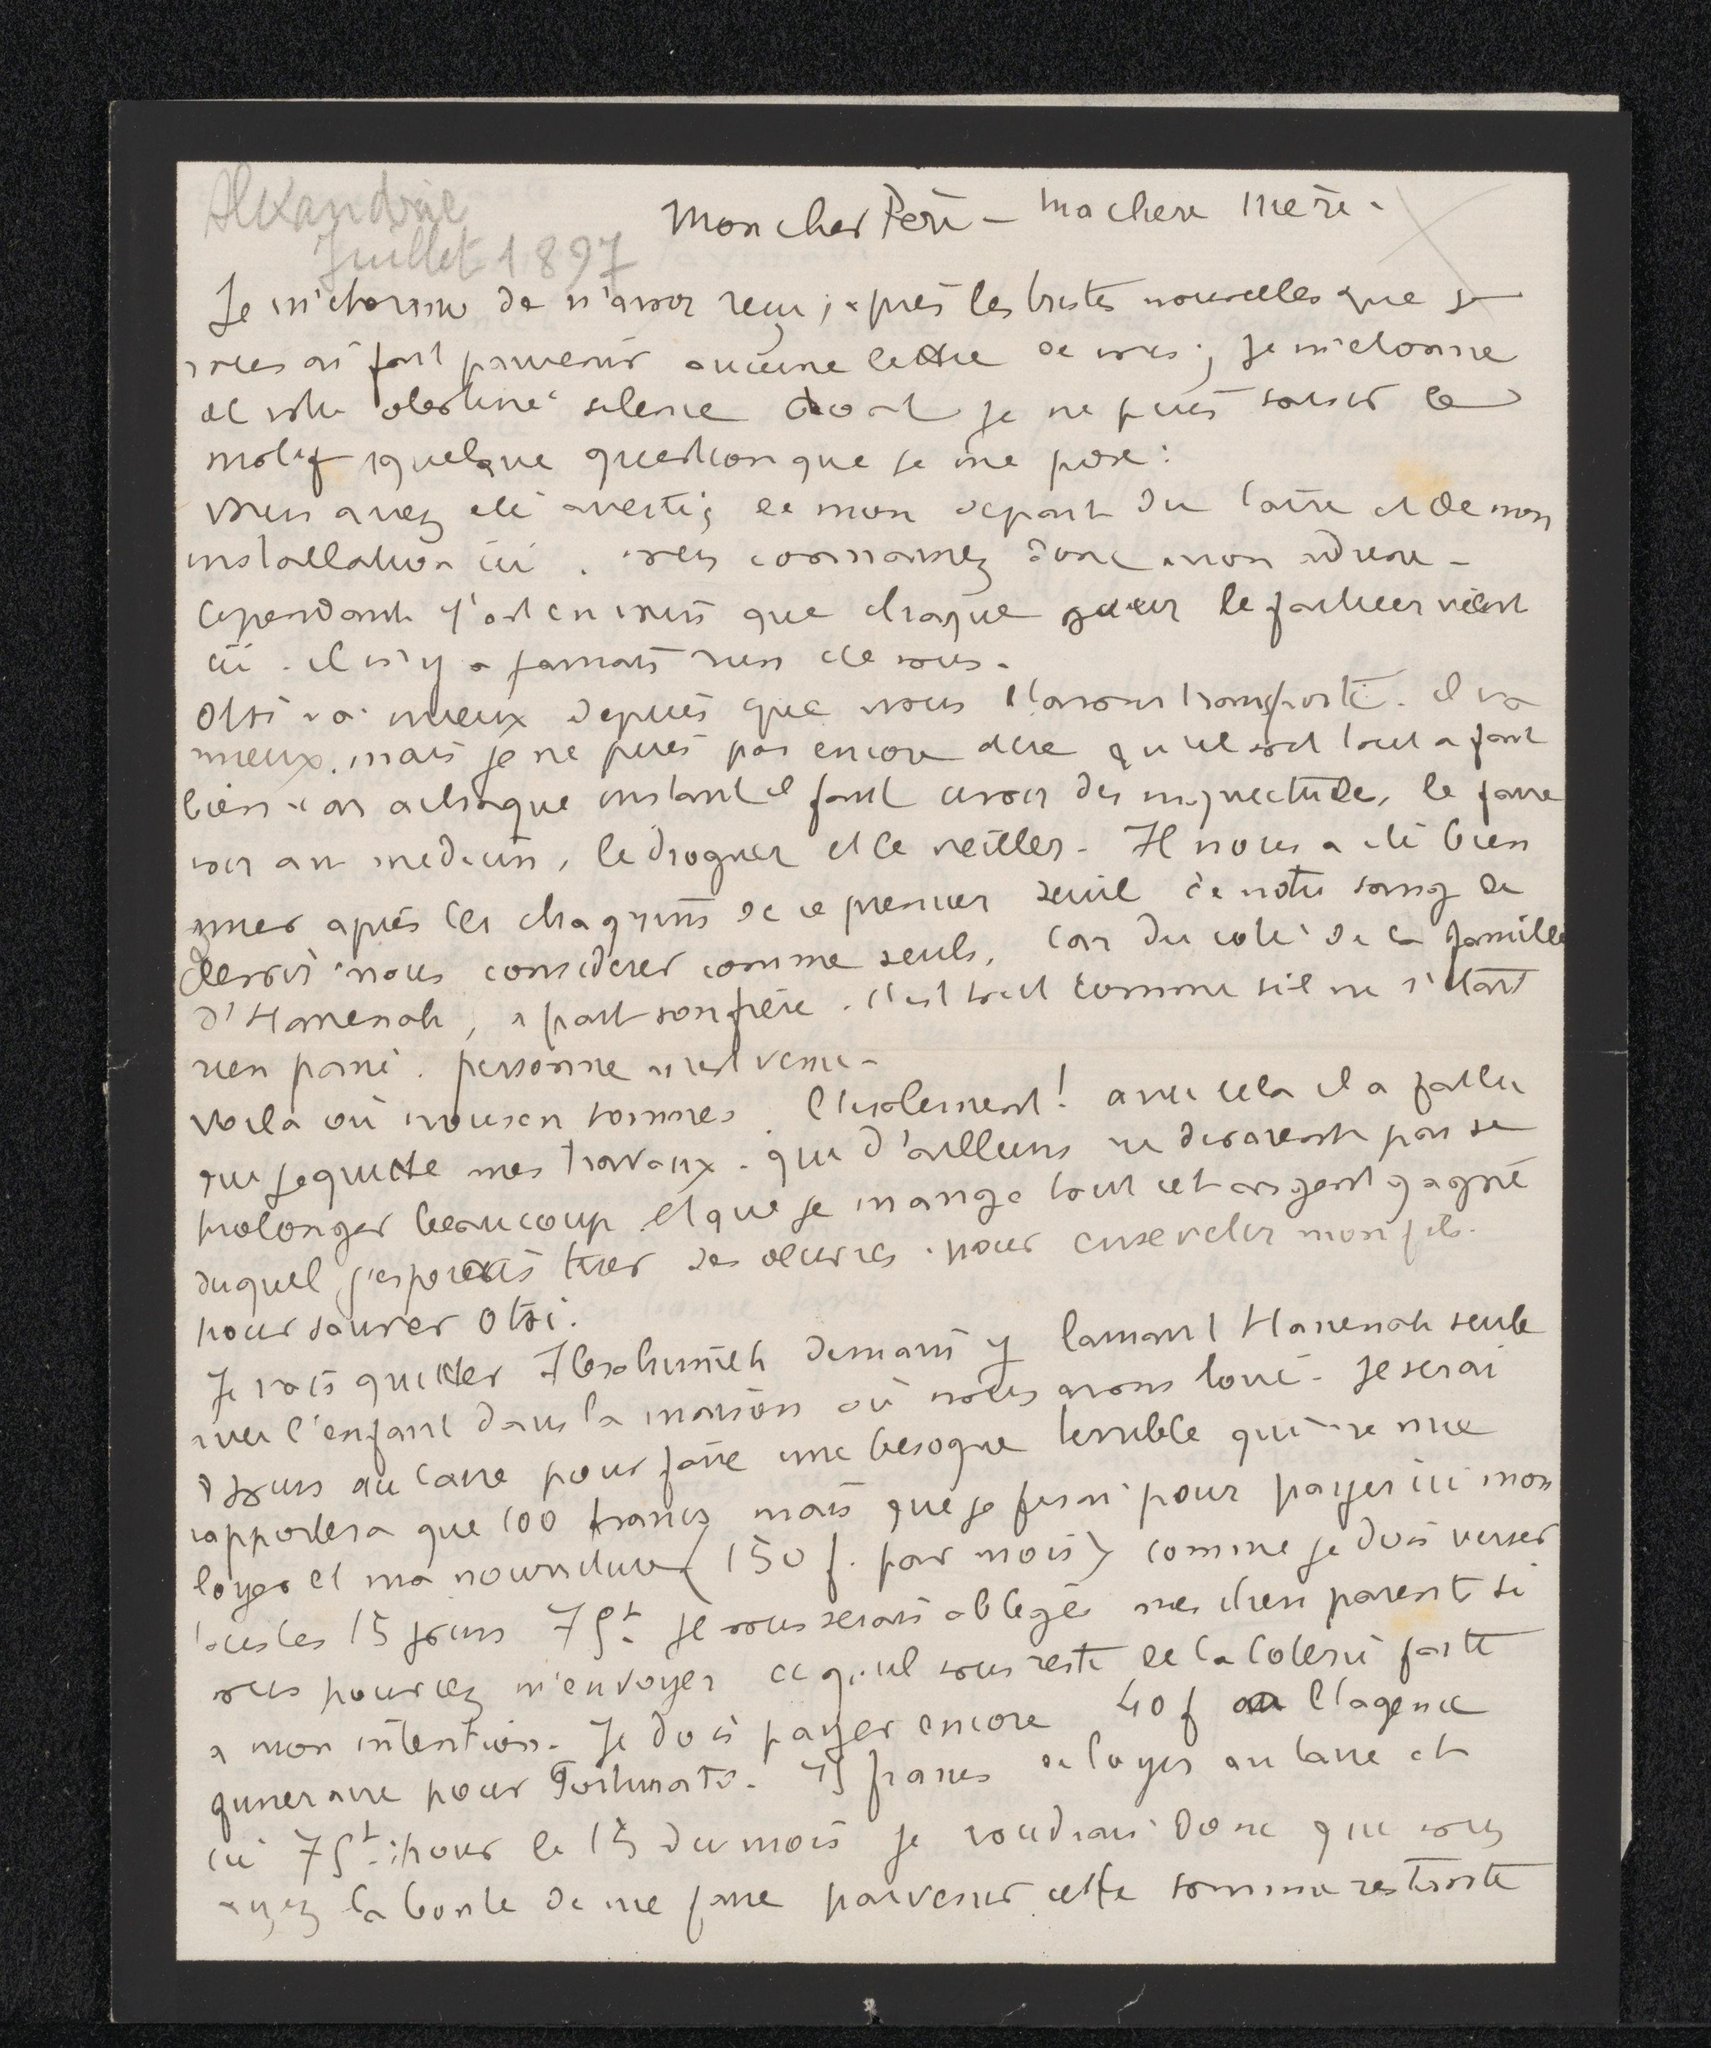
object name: letter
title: Brief aan Emile Ernest Bernard en Héloïse Bernard-Bodin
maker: émile bernard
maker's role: print maker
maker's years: 1868-1941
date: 1878-1941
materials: ink, paper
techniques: pen, writing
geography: alexandria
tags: héloïse bernard-bodin, emile ernest bernard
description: Brief gedateerd Juillet 1897 in latere hand.